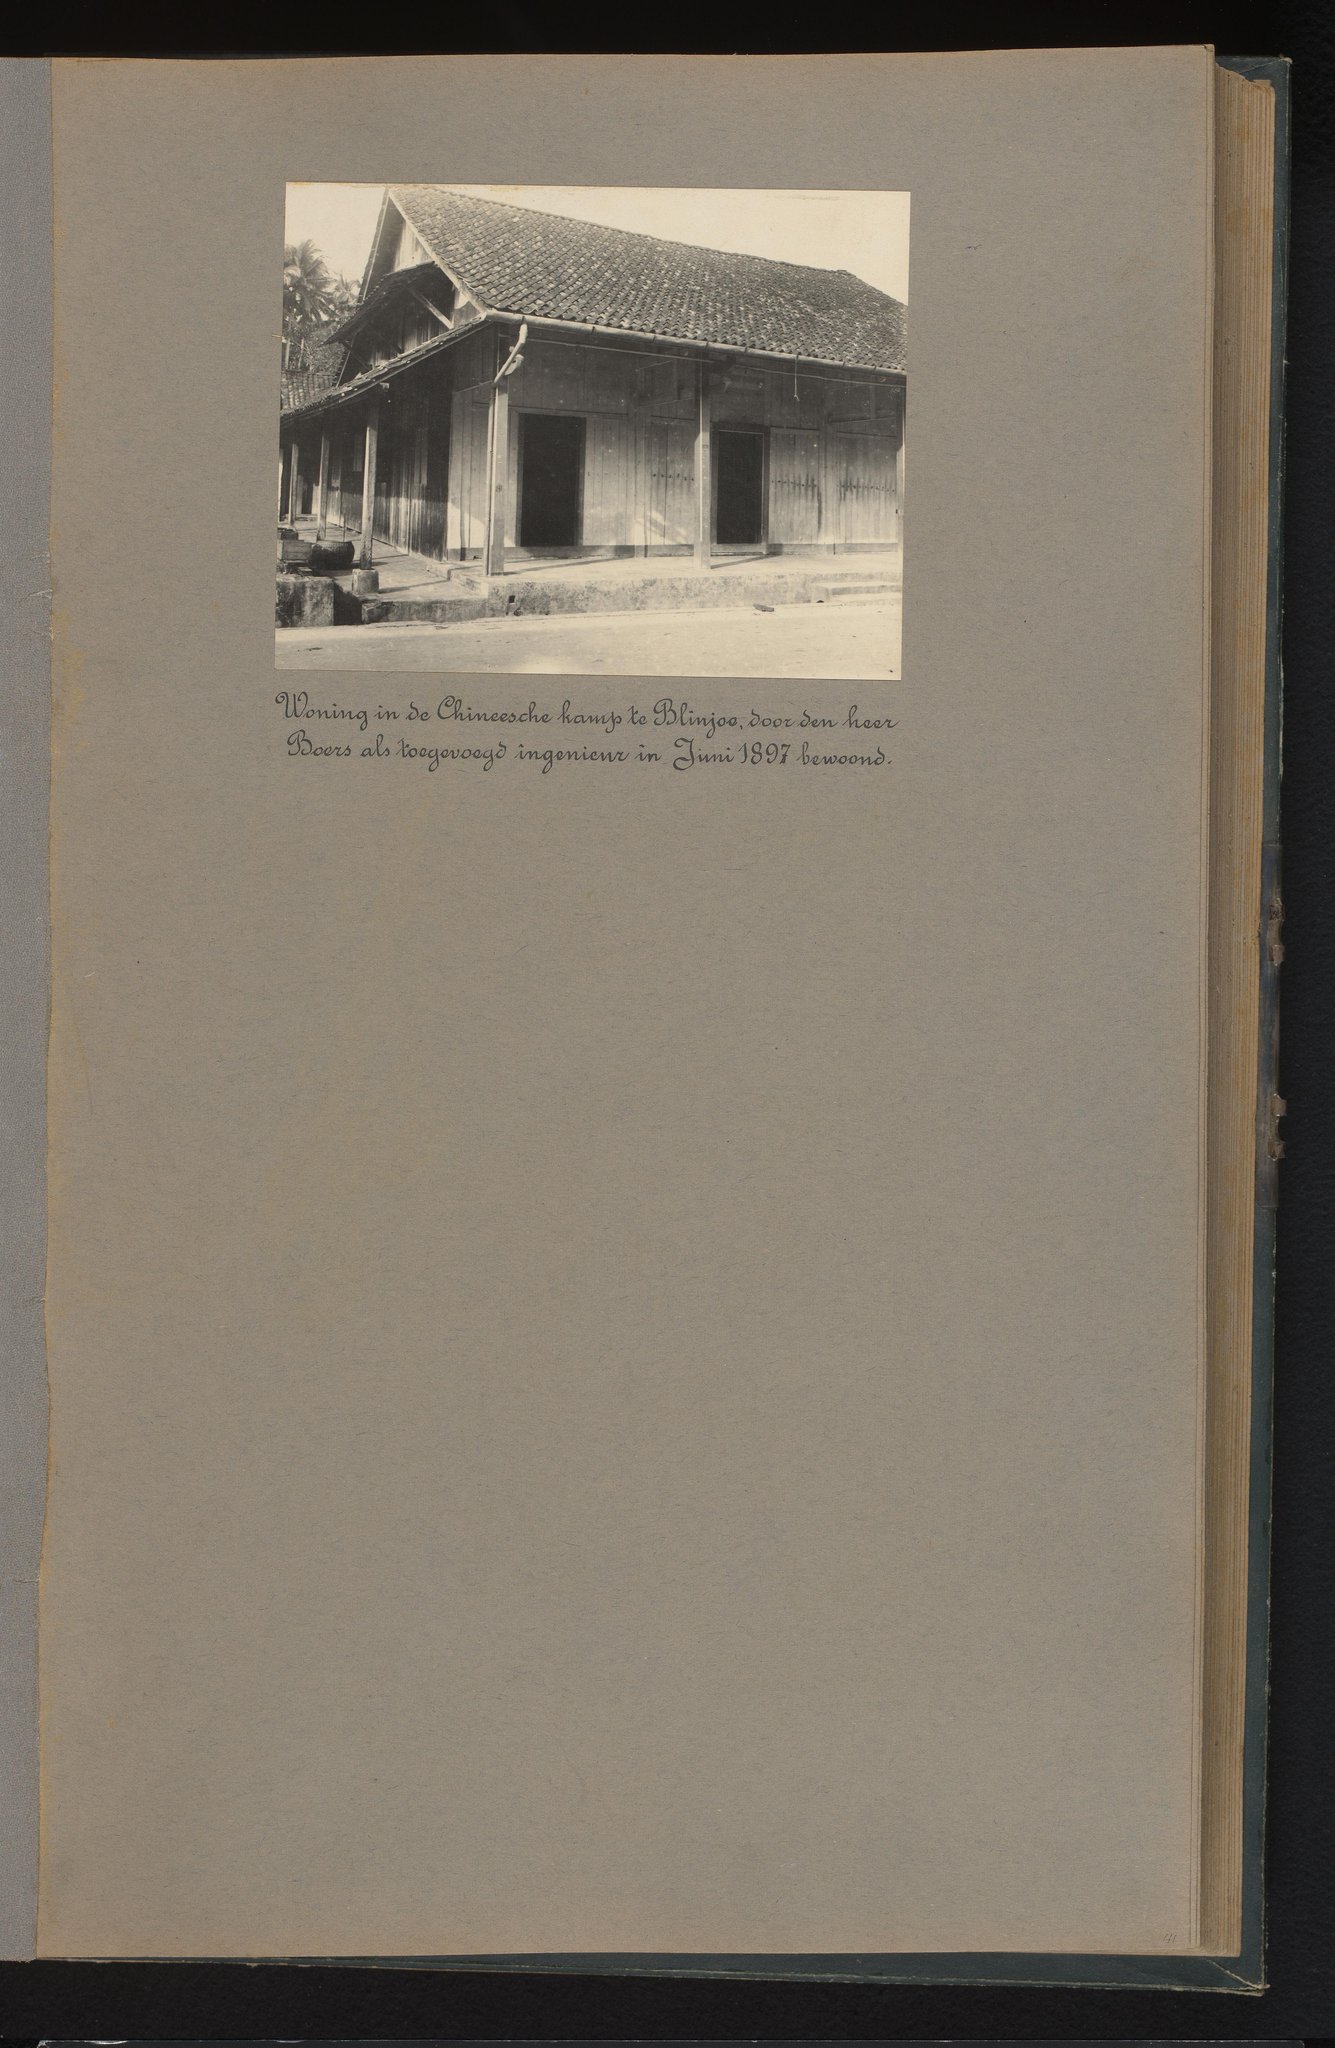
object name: photograph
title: Woning in het Chinese kamp te Blinjoe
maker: Anonymous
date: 1914-1919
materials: cardboard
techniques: gelatin silver print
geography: bangka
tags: robert julius boers, colonial system, mining, cottage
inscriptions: inscription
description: Albumblad met een foto van de woning in het Chinese kamp te Blinjoe, waar de heer Boers als ingenieur in juni 1897 gewoond heeft. Onderdeel van het fotoalbum aangeboden aan Robert Julius Boers bij zijn vertrek naar Nederland in 1919 door het personeel van de Banka-tinwinning.